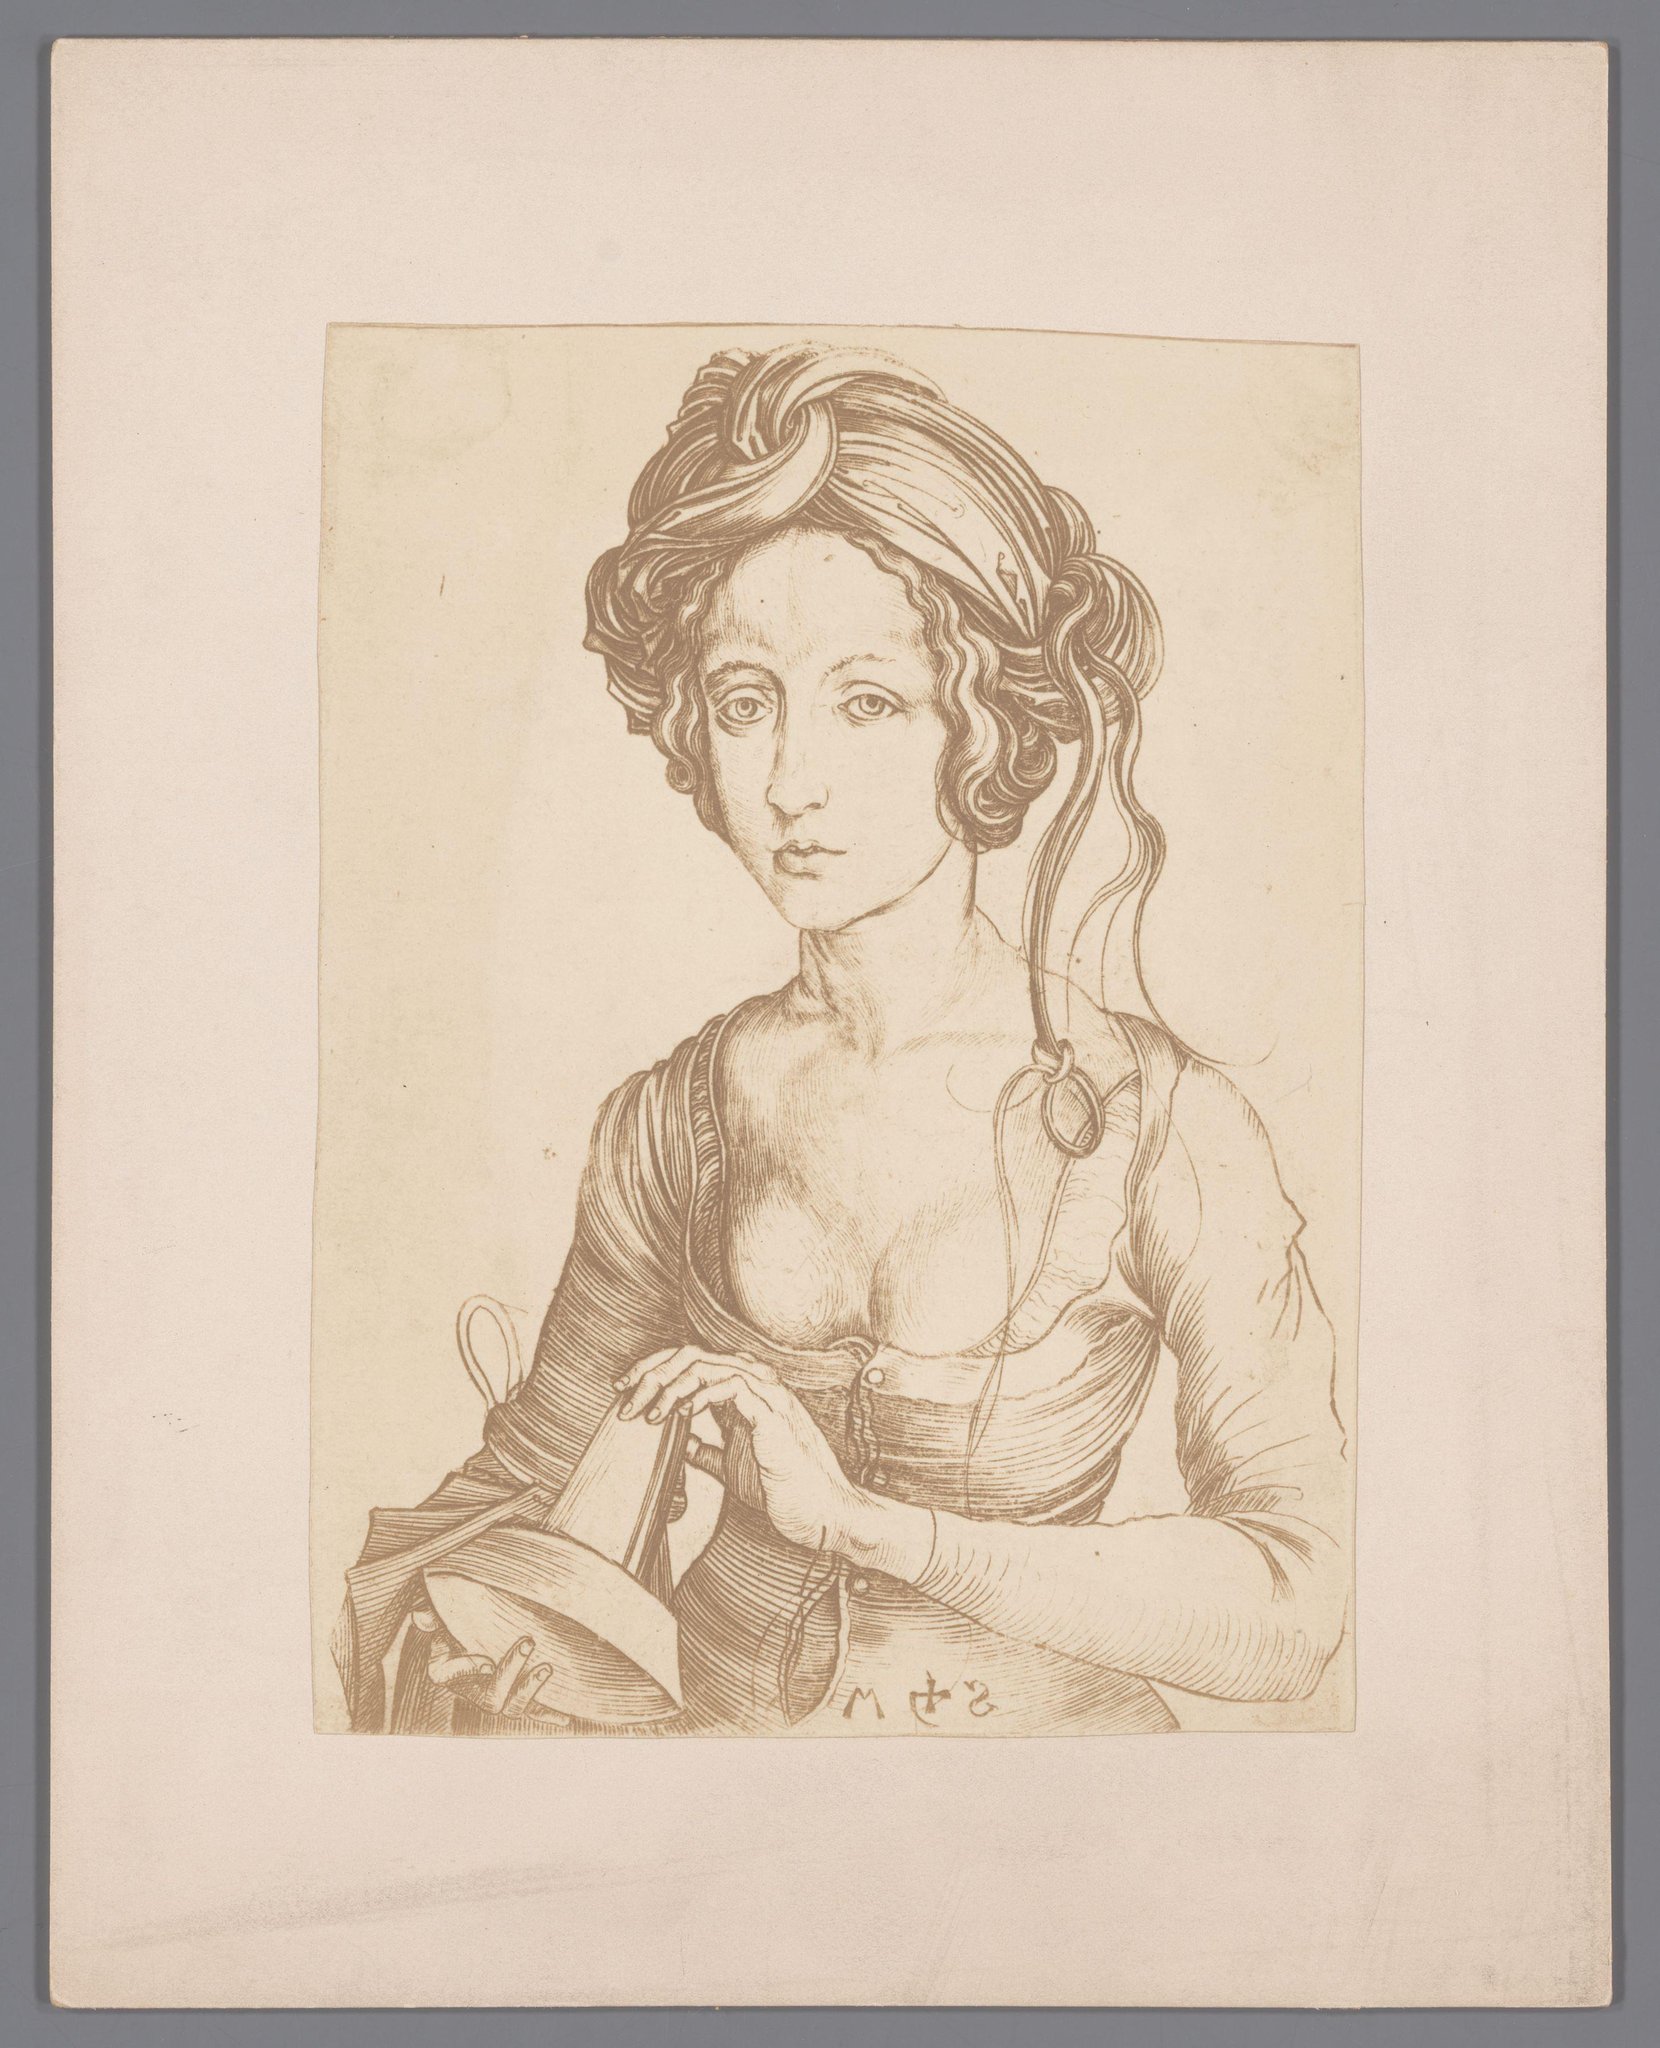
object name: reproduction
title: Fotoreproductie van een gravure van een dwaze maagd door Martin Schongauer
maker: Anonymous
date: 1910-1940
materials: paper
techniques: gelatin silver print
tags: drawing, sketch, print, e.g.: engraving, etching, lithograph